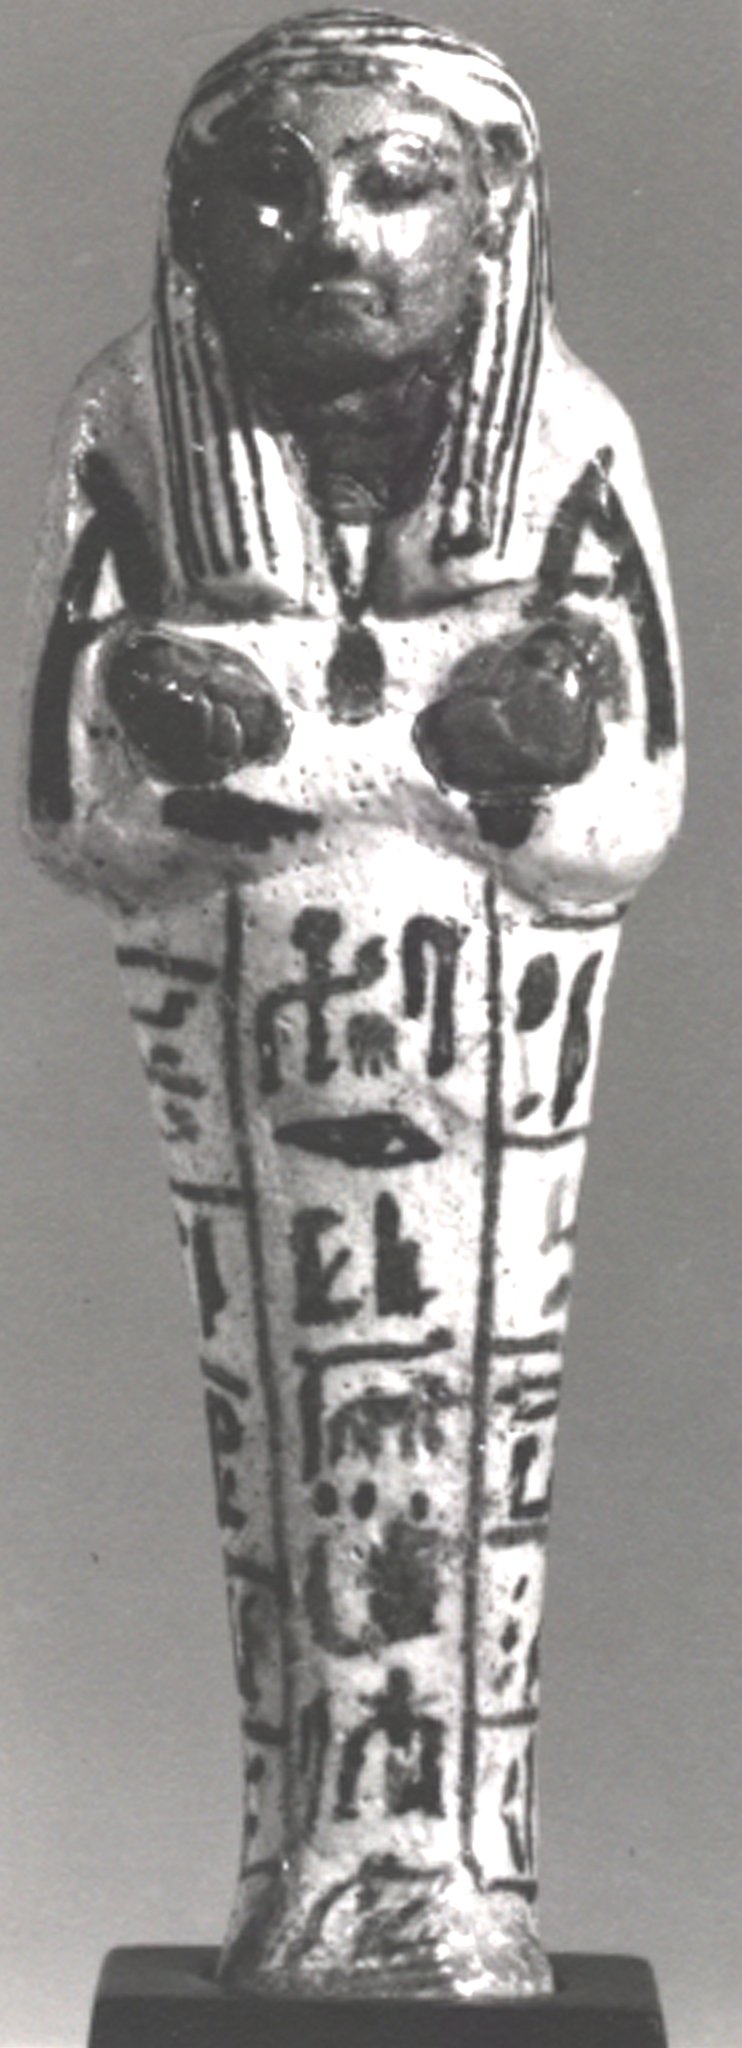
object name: shabti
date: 1295-1070 BCE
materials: faience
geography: egypt